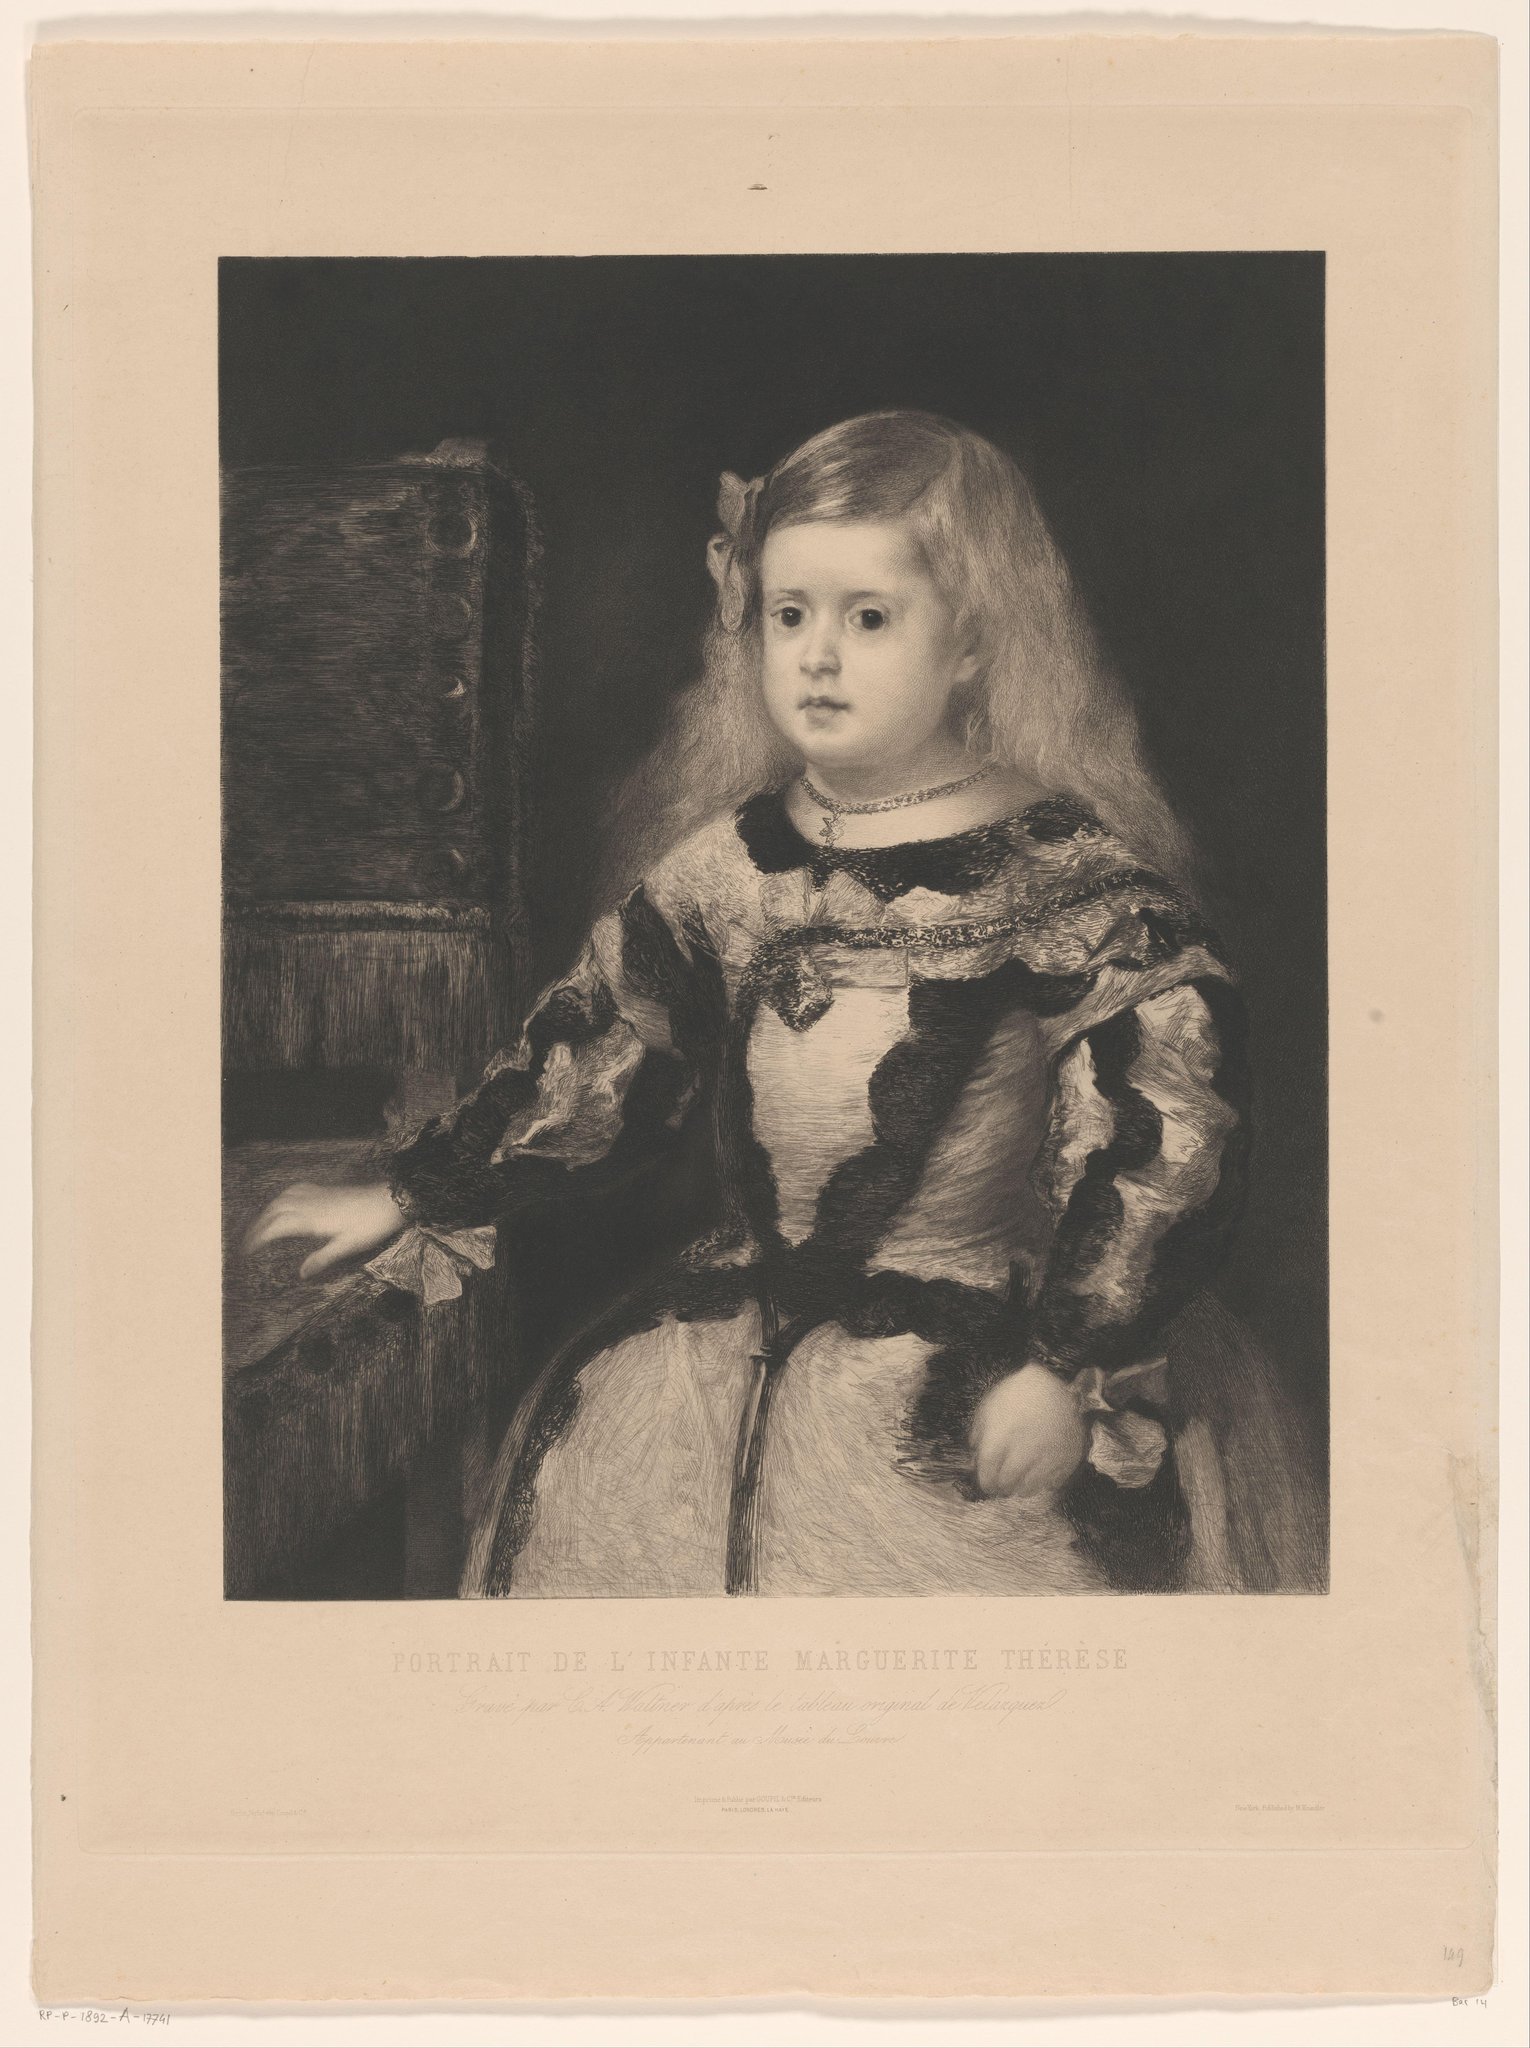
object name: print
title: Portret van Margaretha Theresia van Spanje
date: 1856-1892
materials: paper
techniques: drypoint, etching, intaglio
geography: new york city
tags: historical persons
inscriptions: collector's mark: Lugt 2228